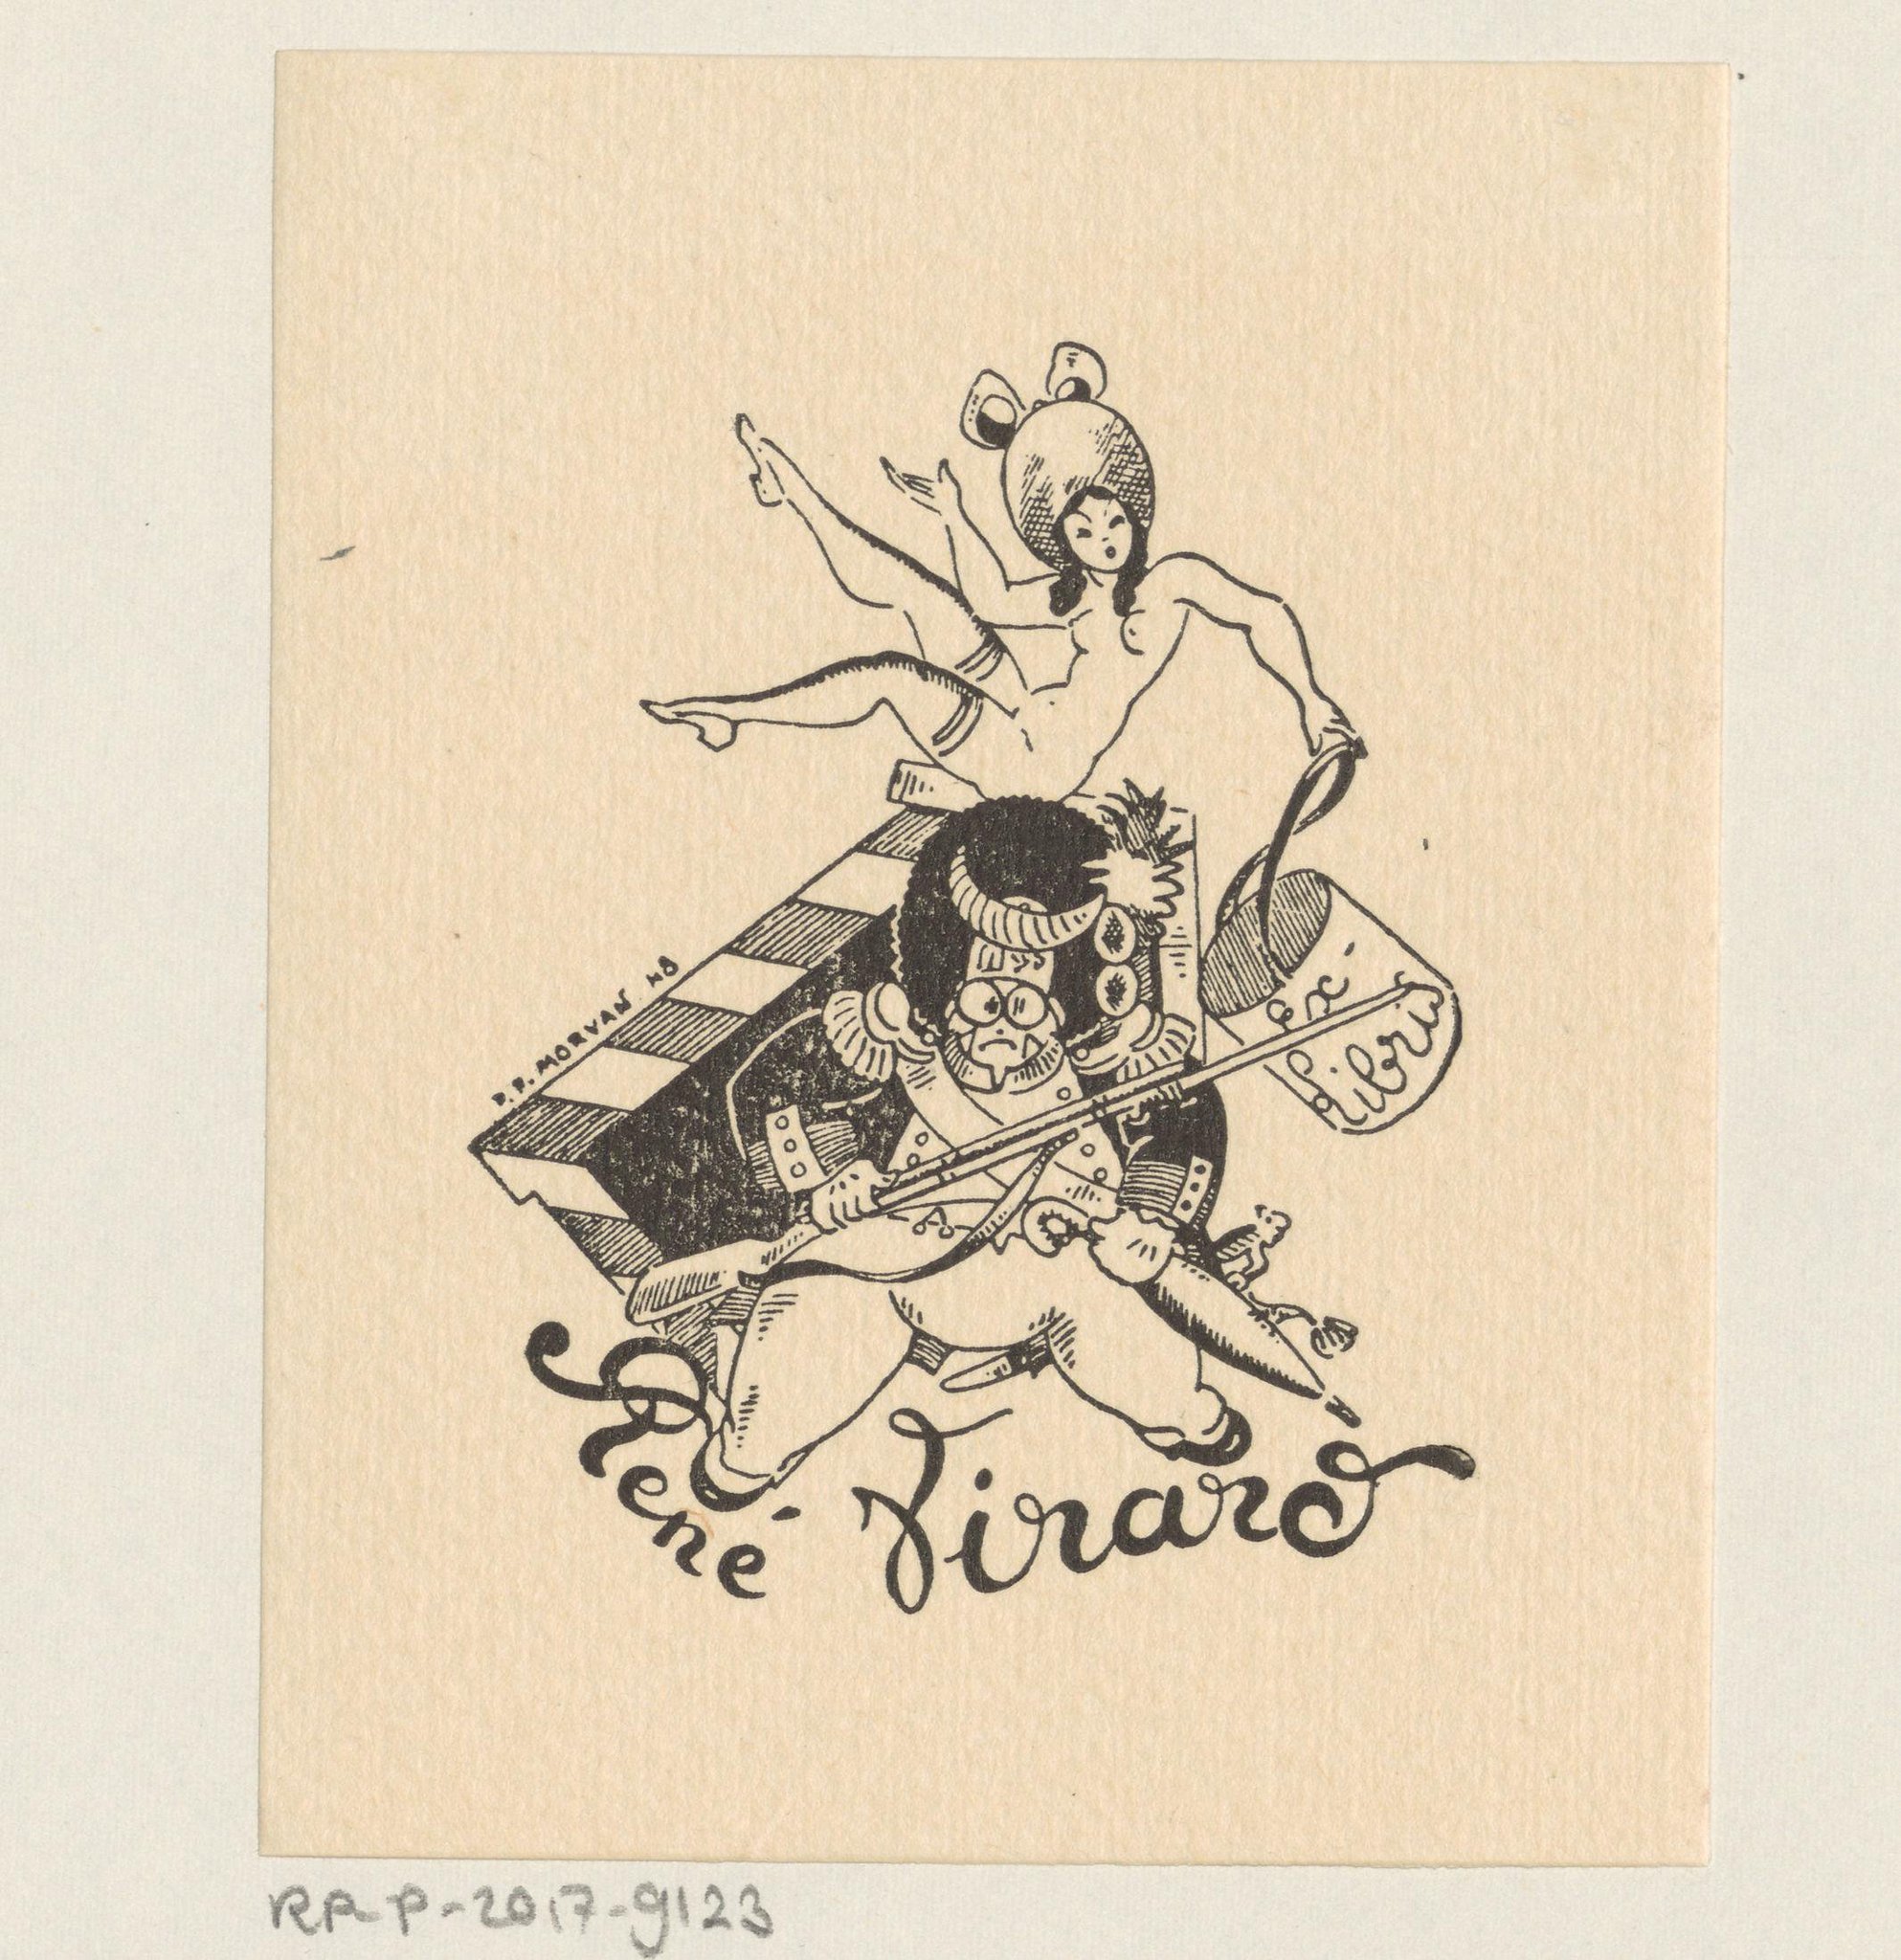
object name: bookplate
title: Ex libris van René Virard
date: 1948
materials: paper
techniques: printing block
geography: france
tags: woman (showing herself) undressed, quasi-nude, (military) uniforms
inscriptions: date